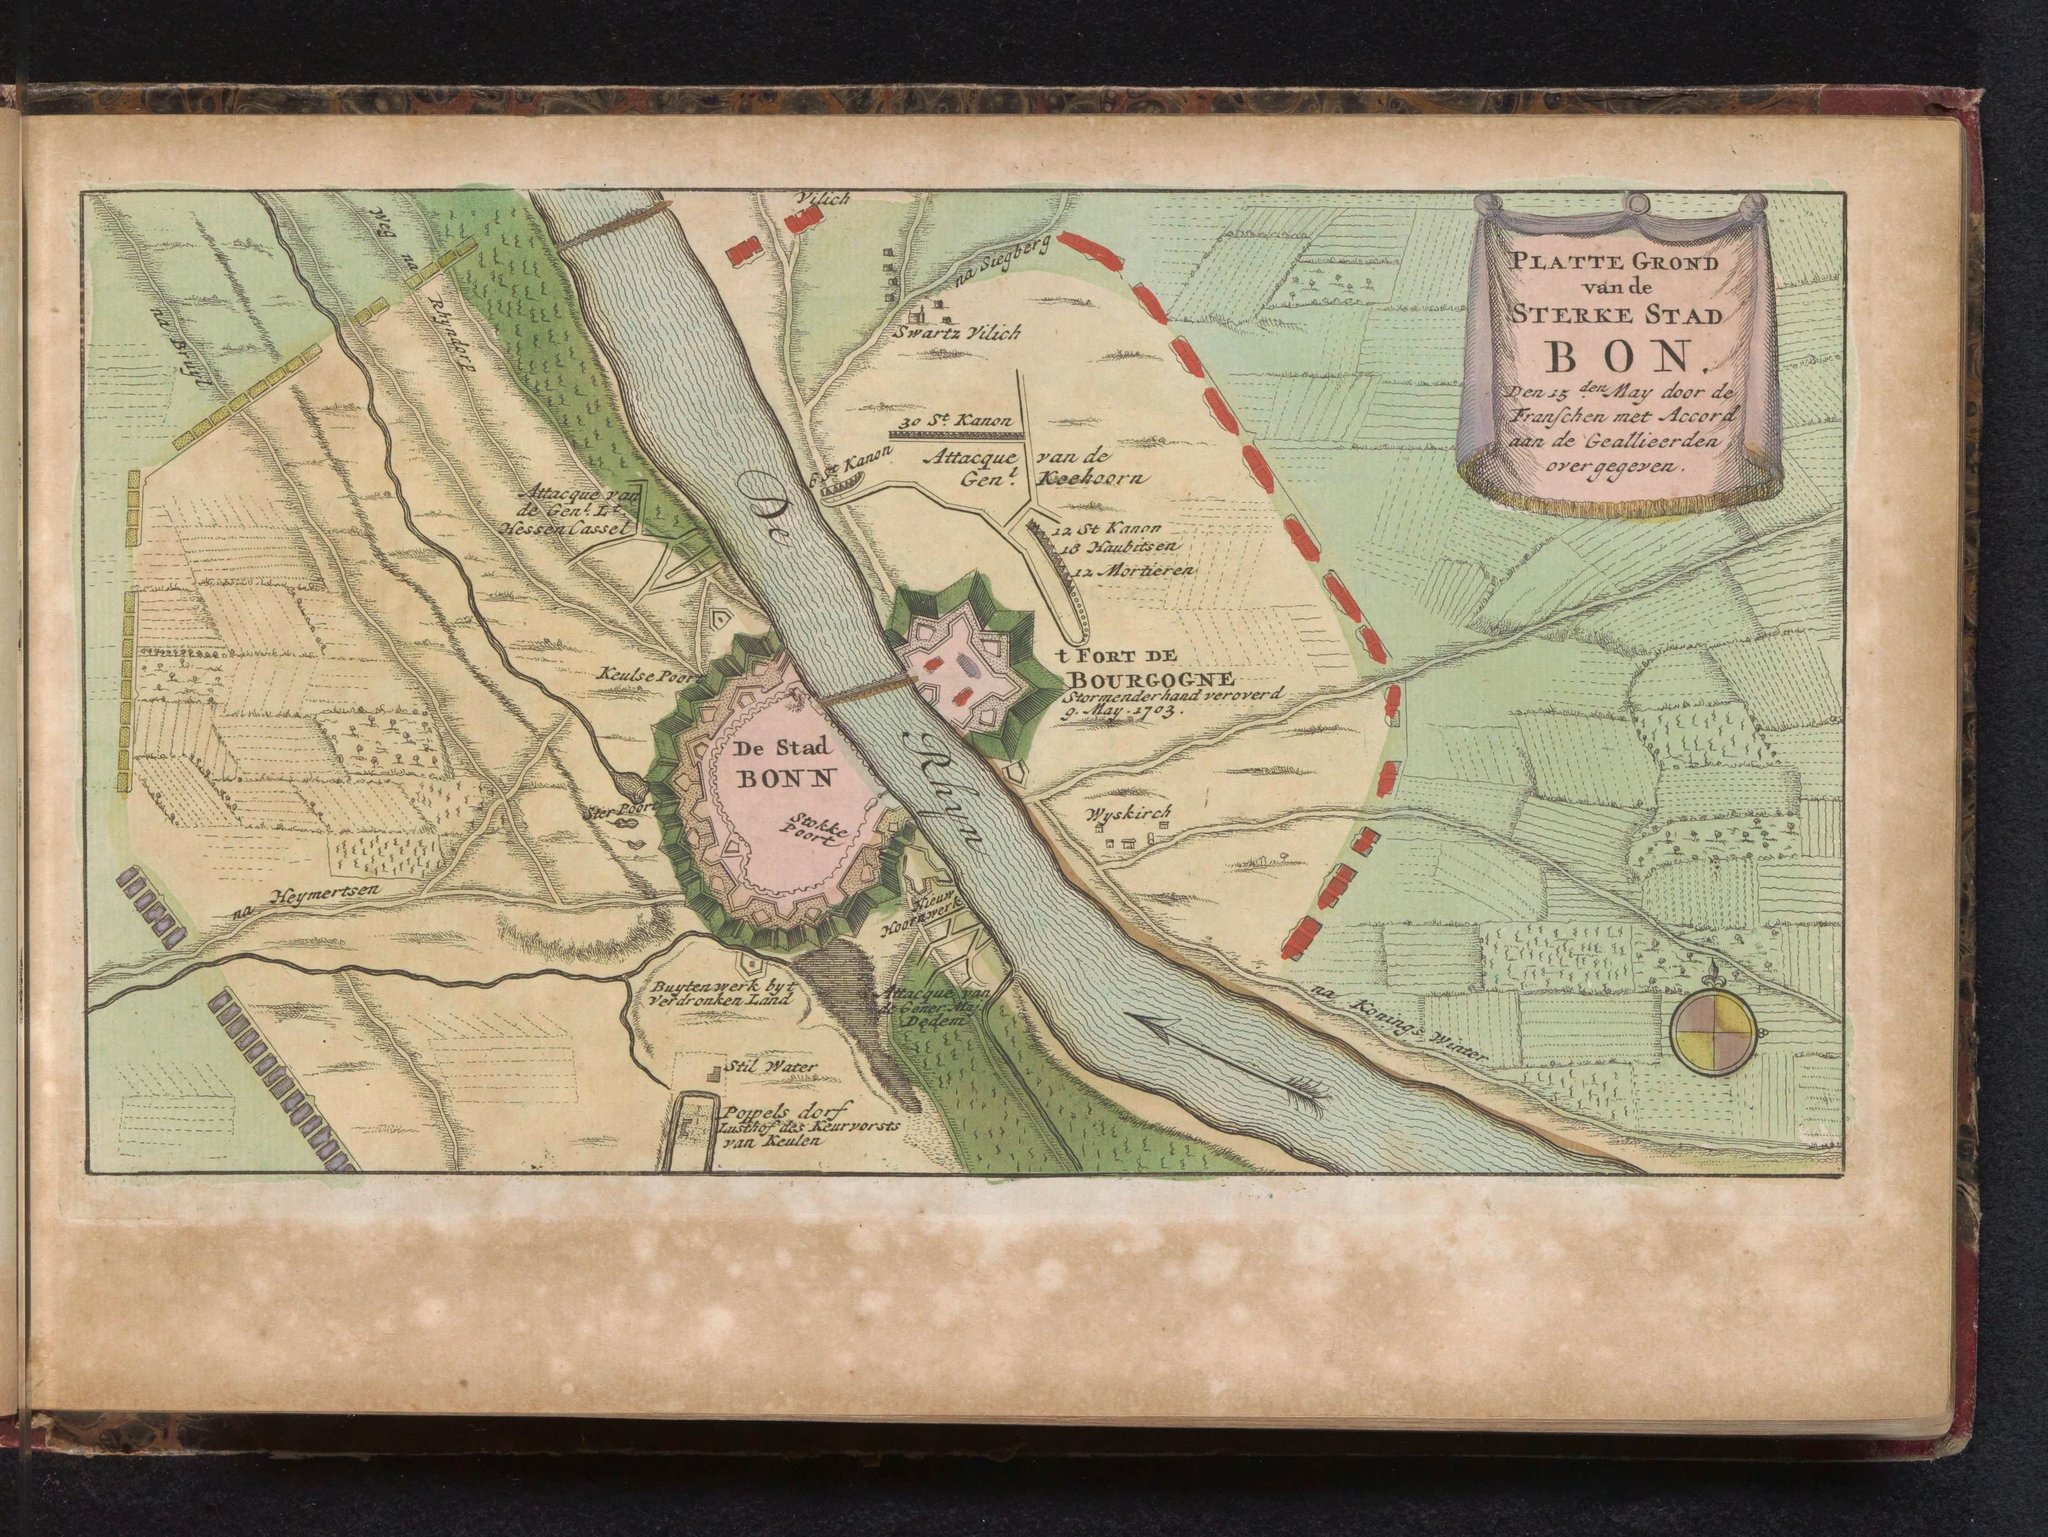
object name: map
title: Platte Grond van de Sterke Stad Bon. Den 15den May door de Franschen met Acoord aan de Geallieerden overgegeven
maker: Anonymous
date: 1700-1702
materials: paper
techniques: engraving, etching, hand coloring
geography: amsterdam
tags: siege, position war, maps of cities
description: Plattegrond van de stad Bonn belegerd en ingenomen door de Geallieerden, 15 mei 1703. Onderdeel van een atlas met 223 kaarten van landen en steden en oorlogstaferelen in Europa in de periode ca. 1690-1735.